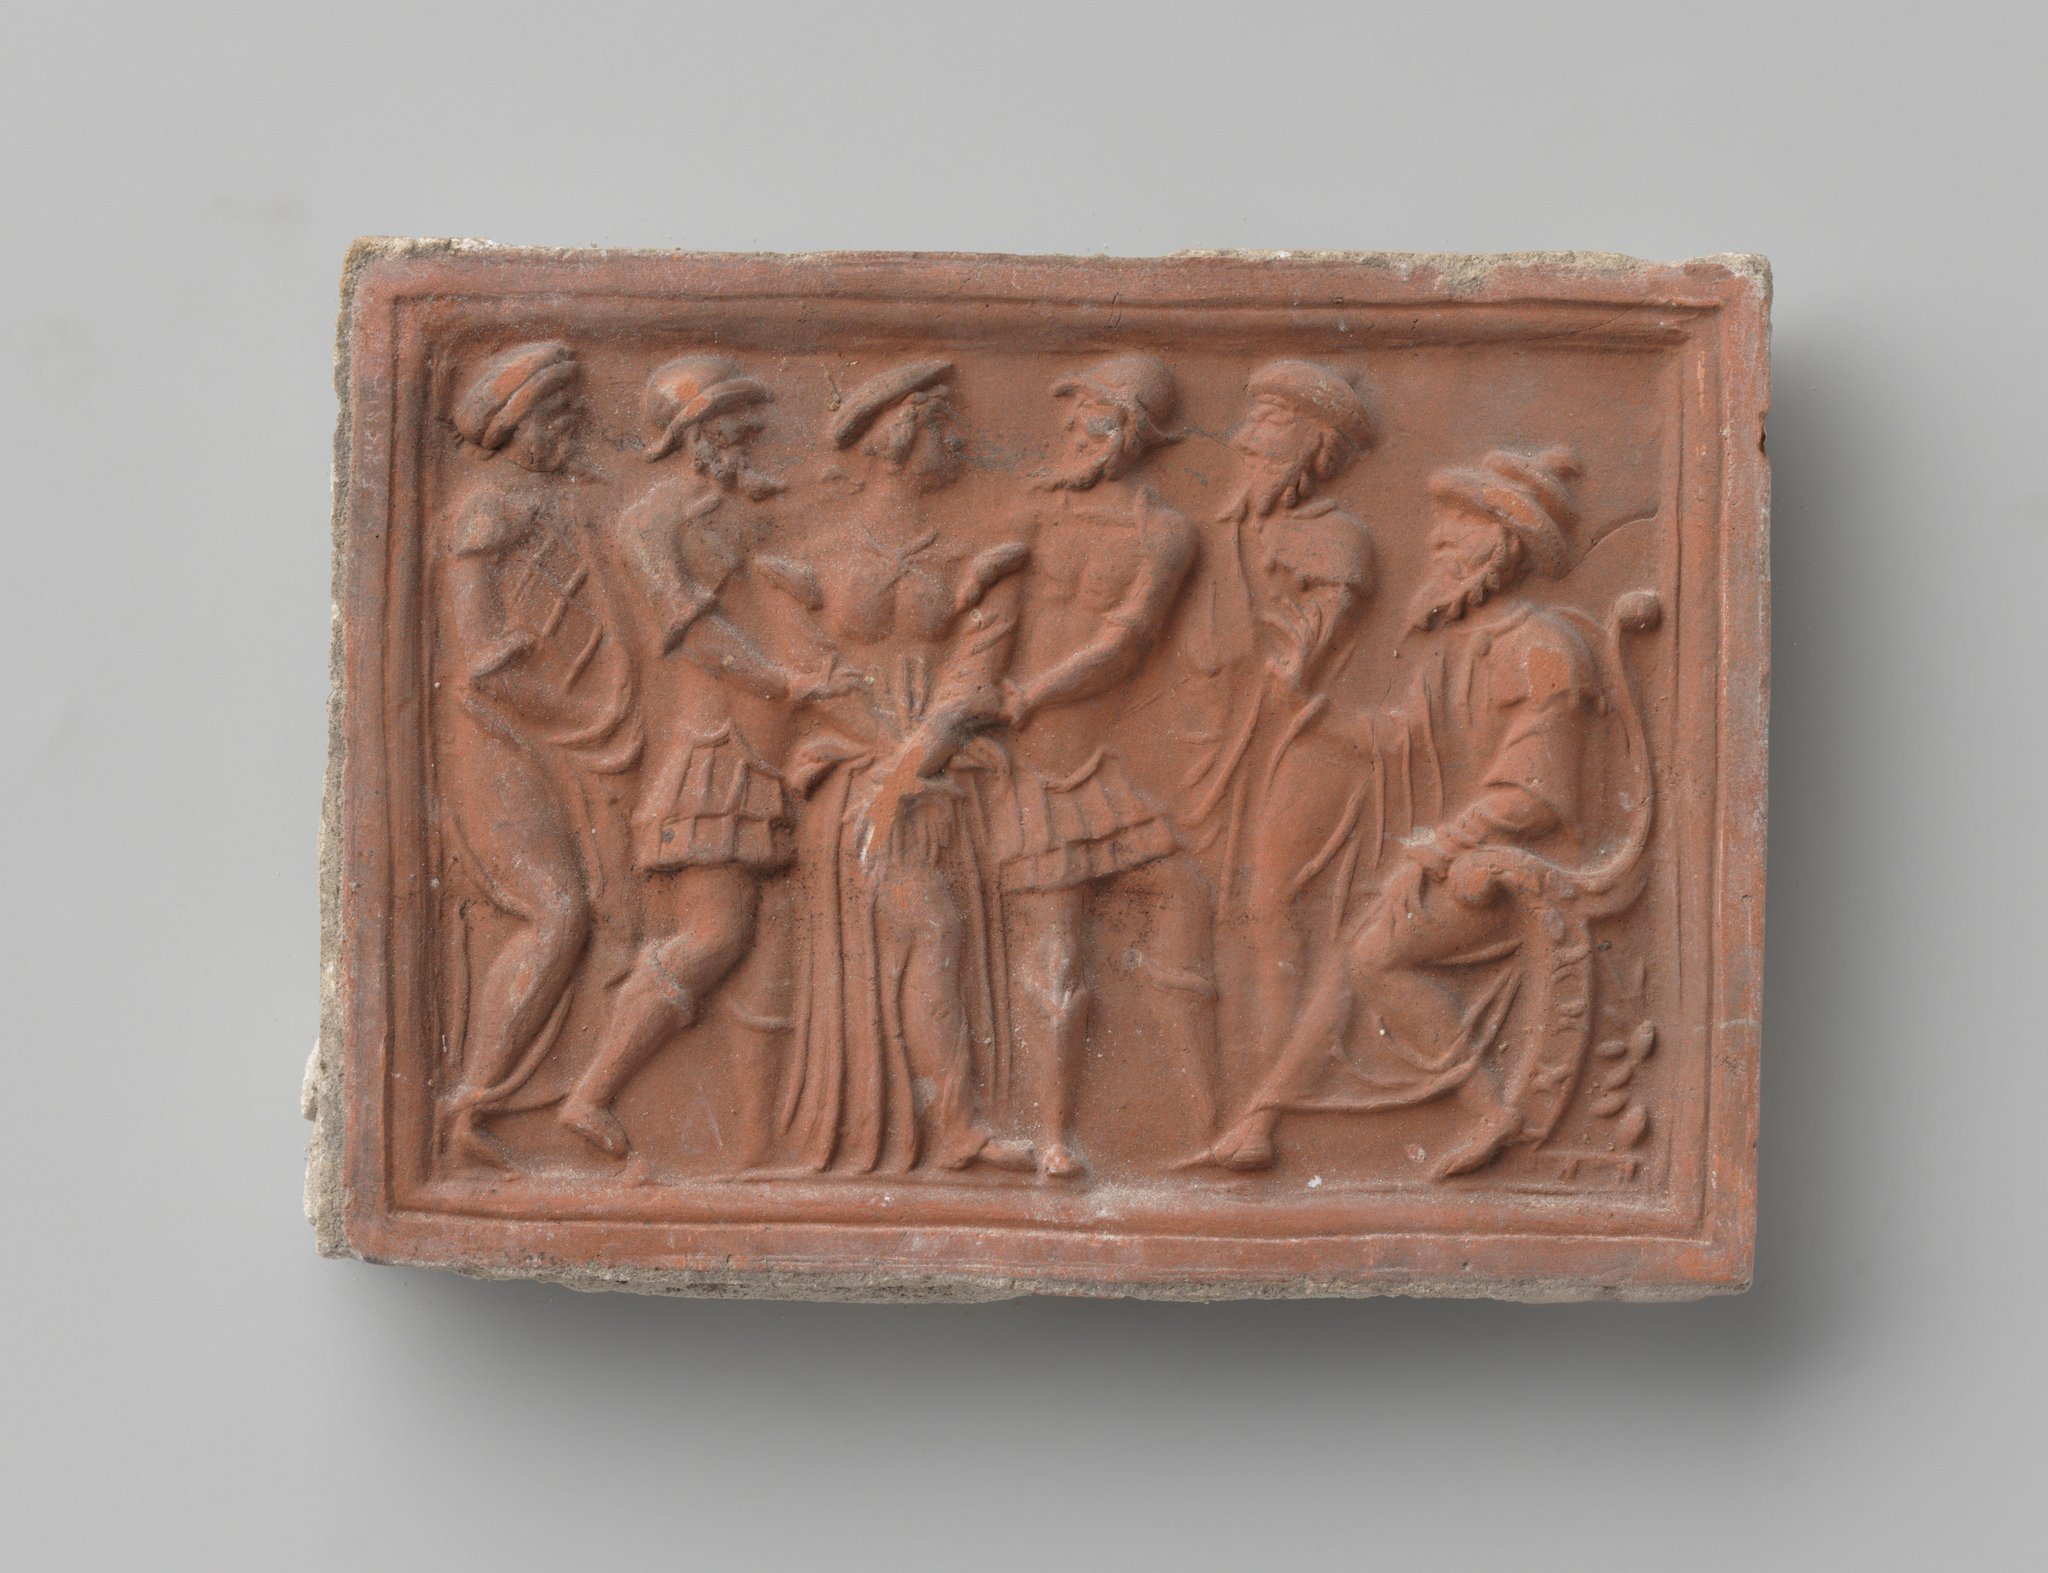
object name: hearthstone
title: Haardsteen met voorstelling van Suzanna, die door de twee ouderlingen voor de rechter wordt gevoerd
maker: Anonymous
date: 1875-1900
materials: earthenware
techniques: printing, firing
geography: netherlands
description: Haardsteen met voorstelling van Suzanna, die door de twee ouderlingen voor de rechter wordt gevoerd.